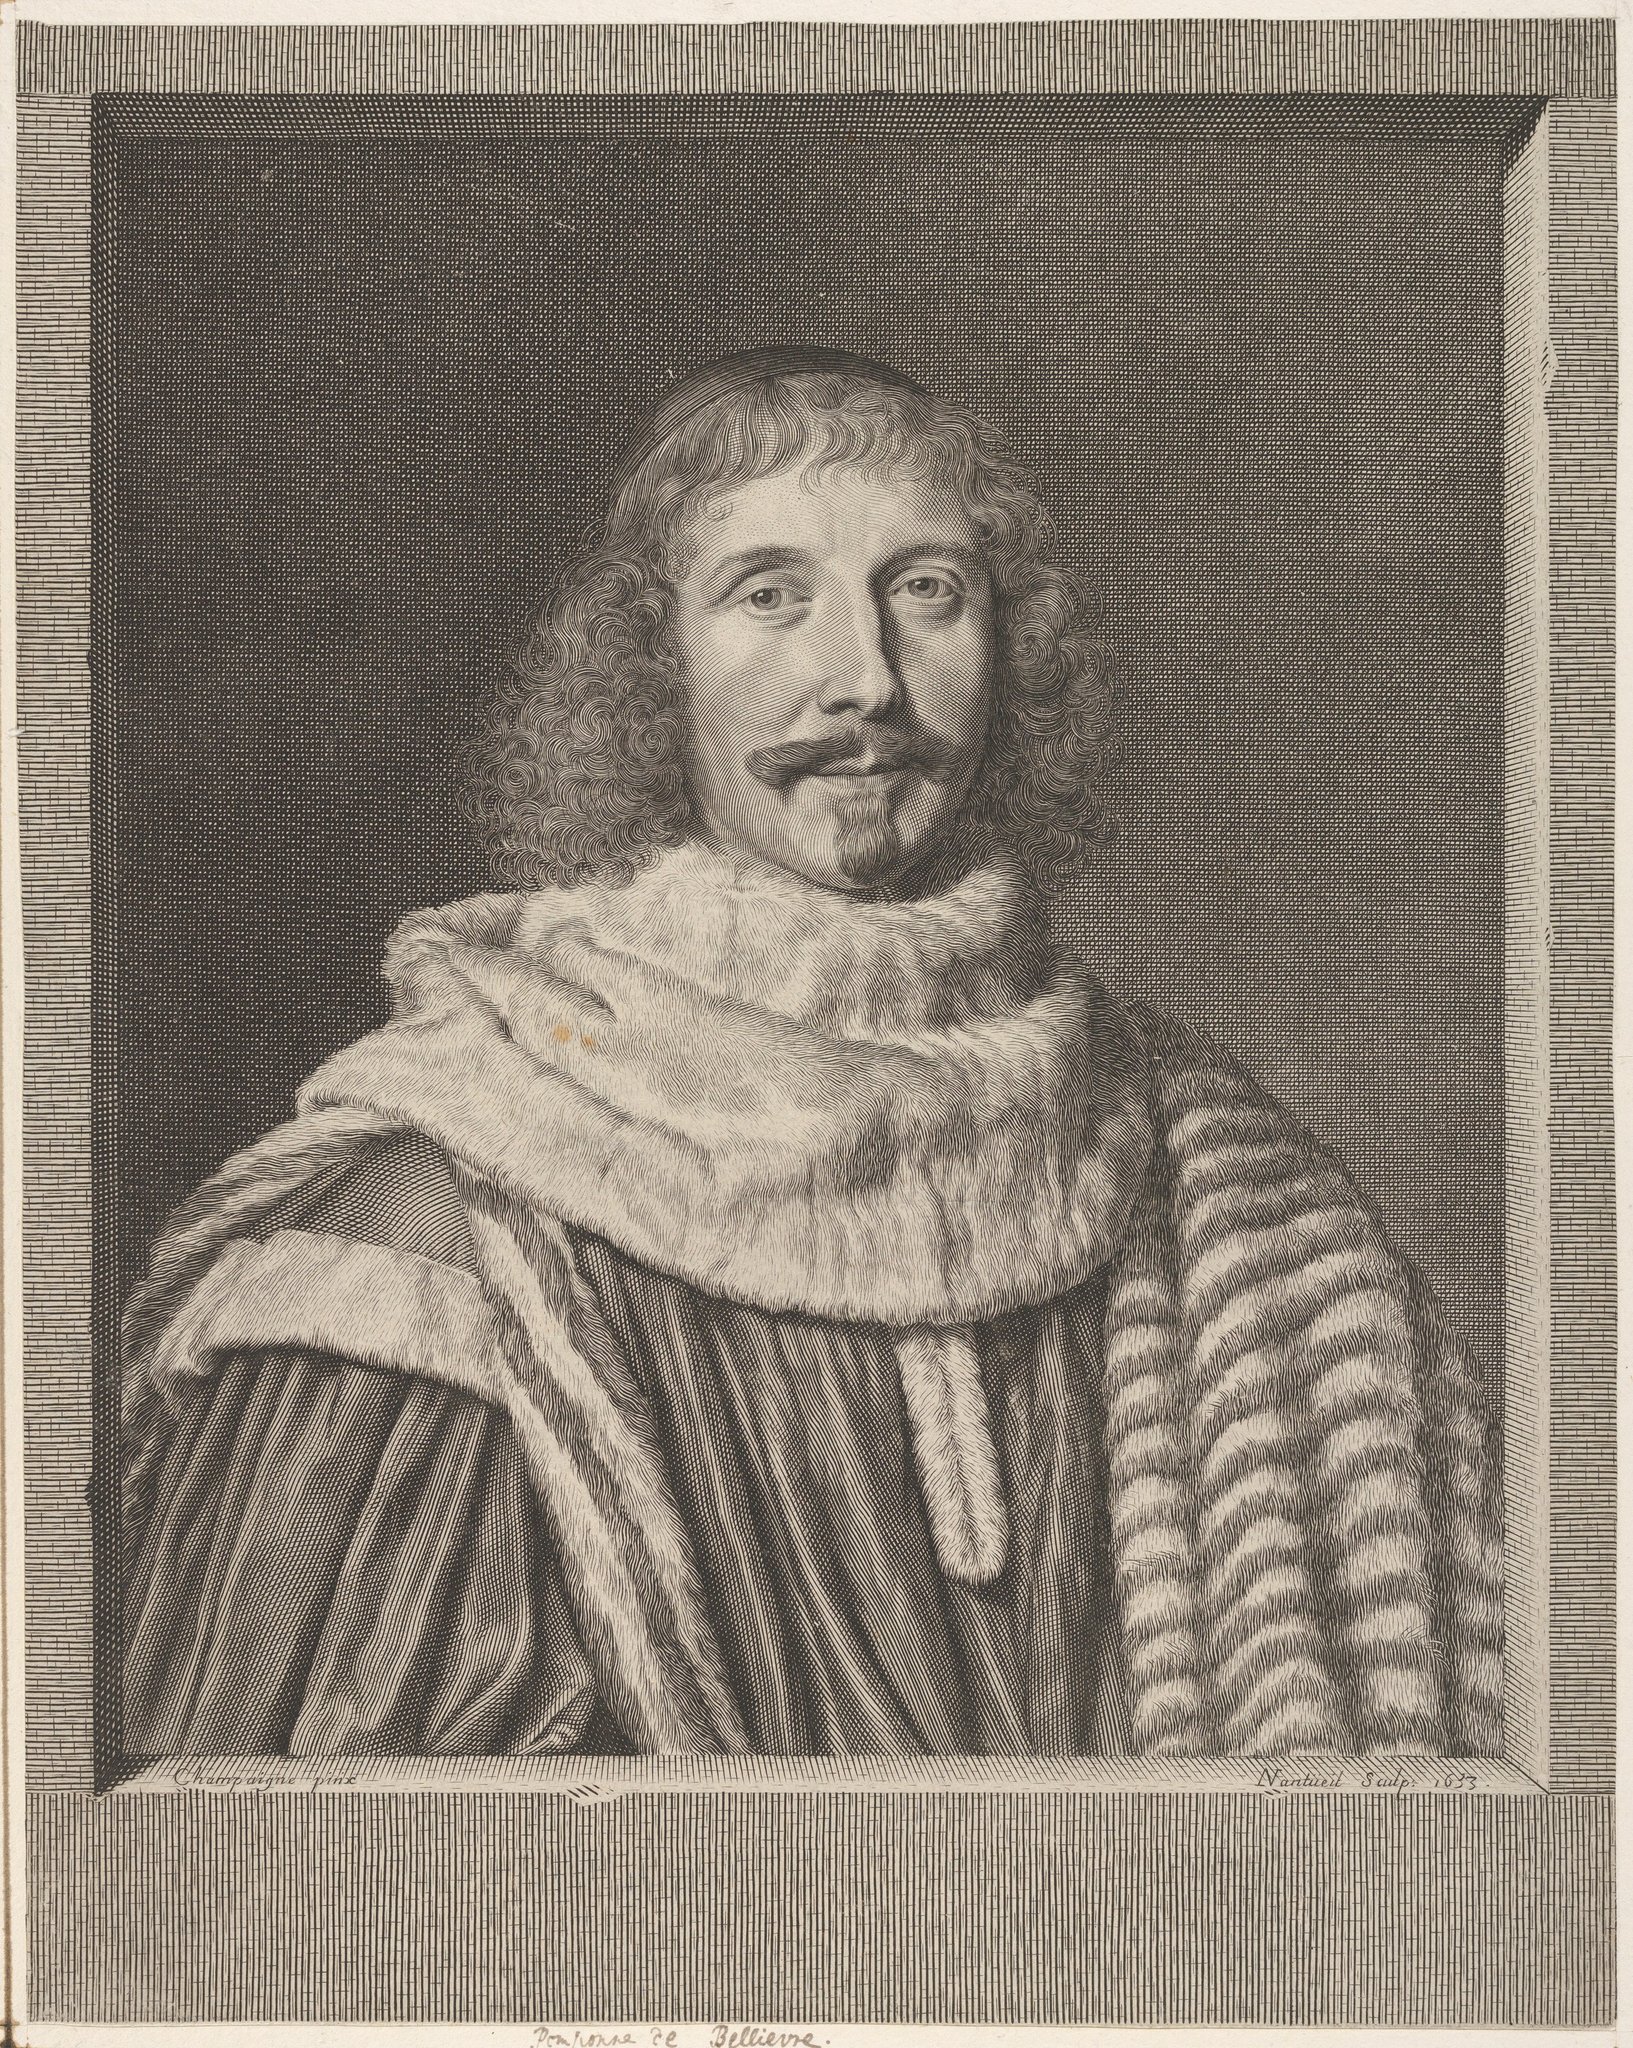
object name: print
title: Pompone II de Bellièvre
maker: robert nanteuil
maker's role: artist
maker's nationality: french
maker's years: 1623-1678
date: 1653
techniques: engraving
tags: men,portraits